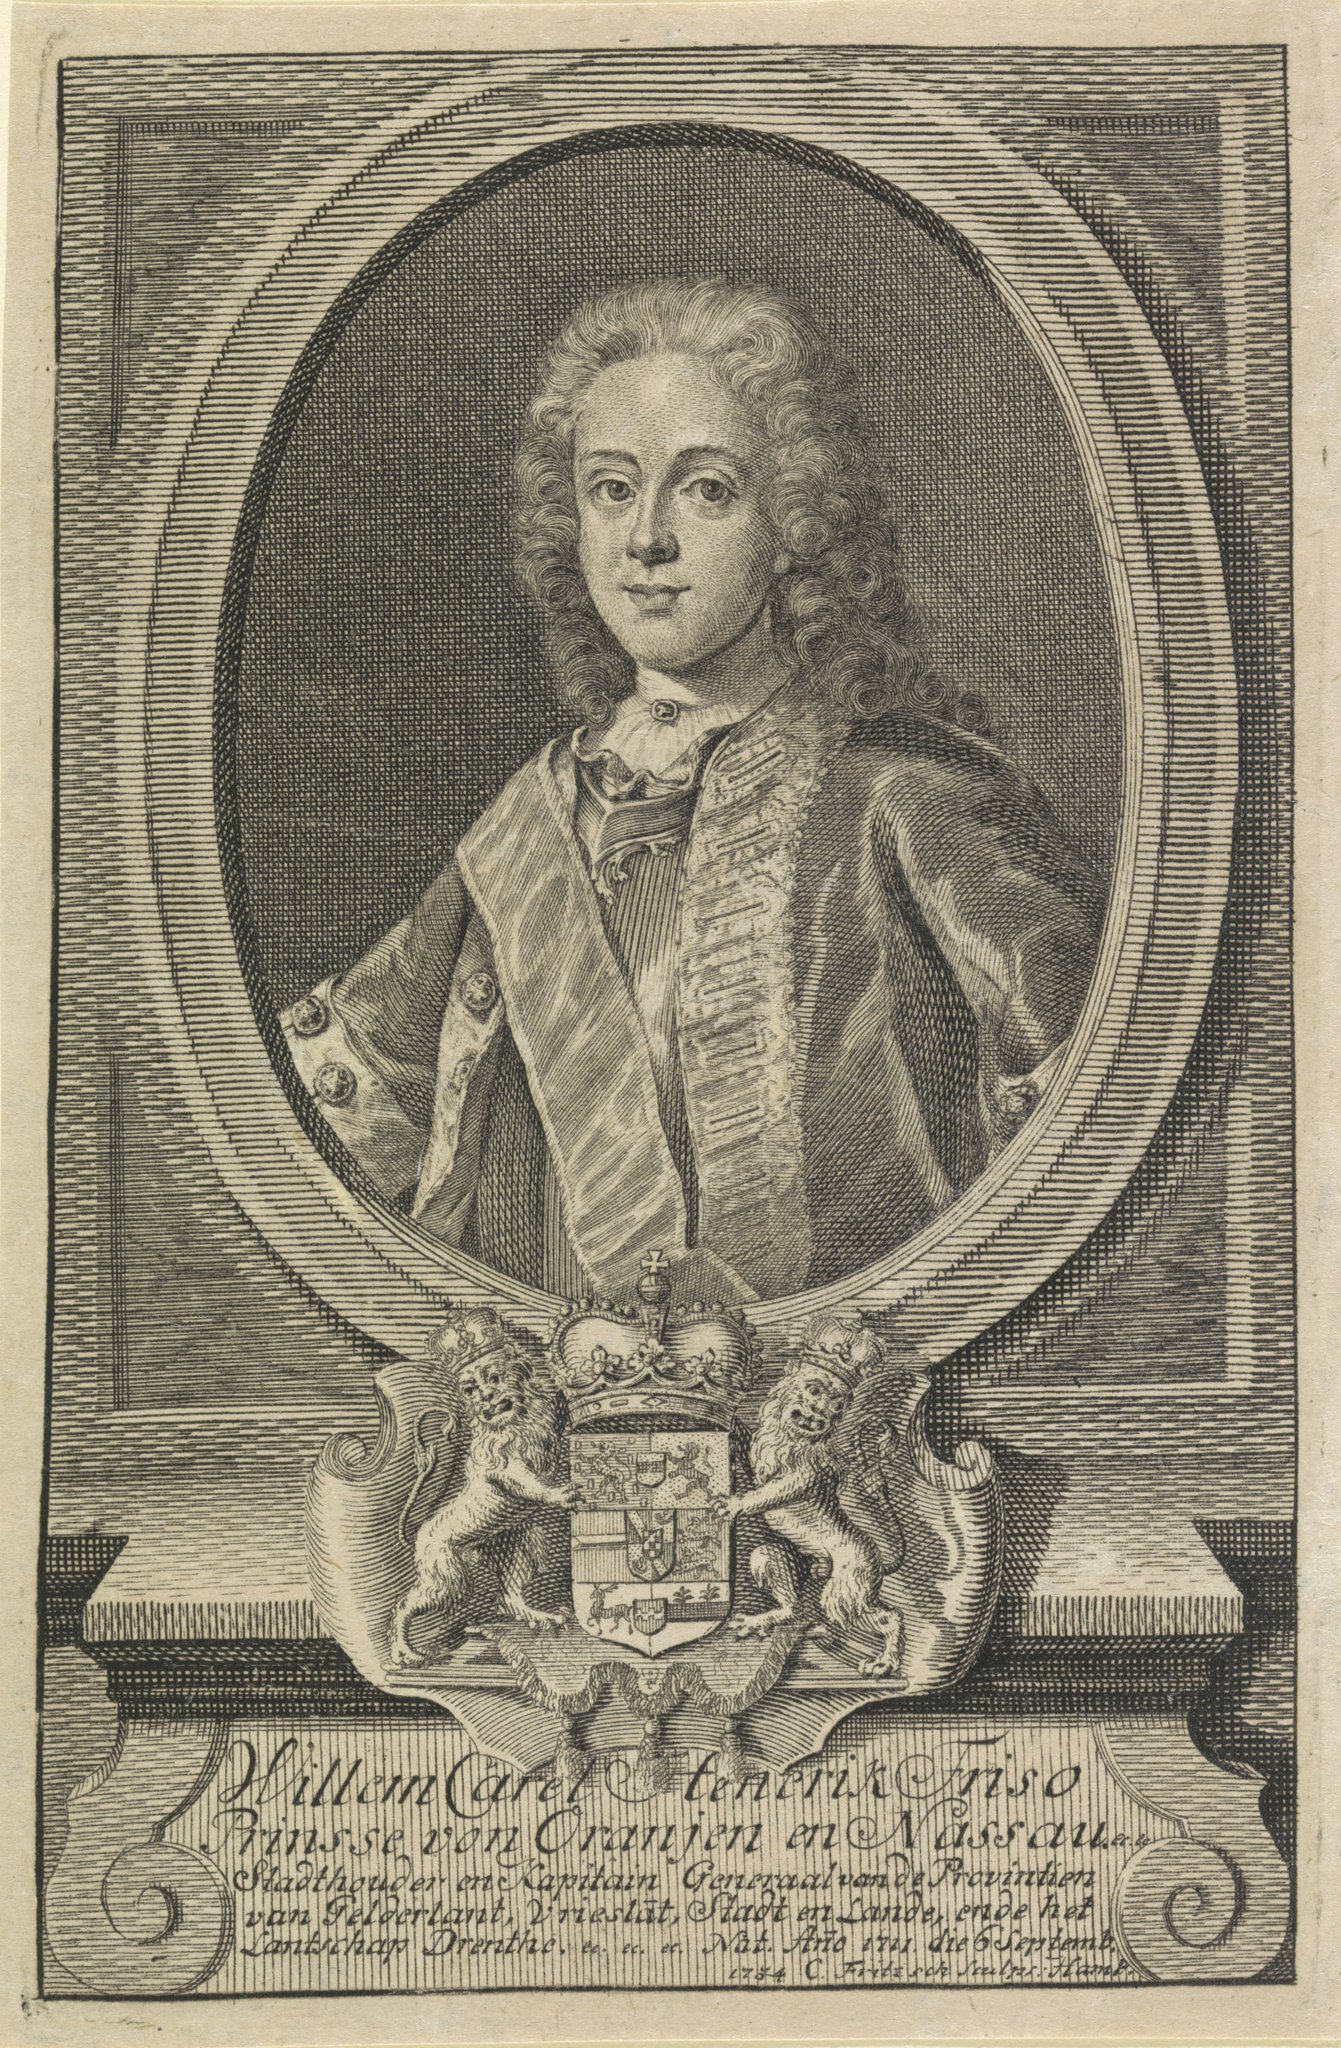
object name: print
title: Portret van Willem IV, prins van Oranje-Nassau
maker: christian friedrich fritzsch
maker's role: print maker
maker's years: 1719-1774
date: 1734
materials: paper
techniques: engraving, etching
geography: hamburg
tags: the hague, willem iv (prins van oranje-nassau)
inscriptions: date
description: De hier vermelde titel verwijst naar de hoogst verkregen titel van de geportretteerde, niet per se naar de titel die de geportretteerde op deze voorstelling draagt.